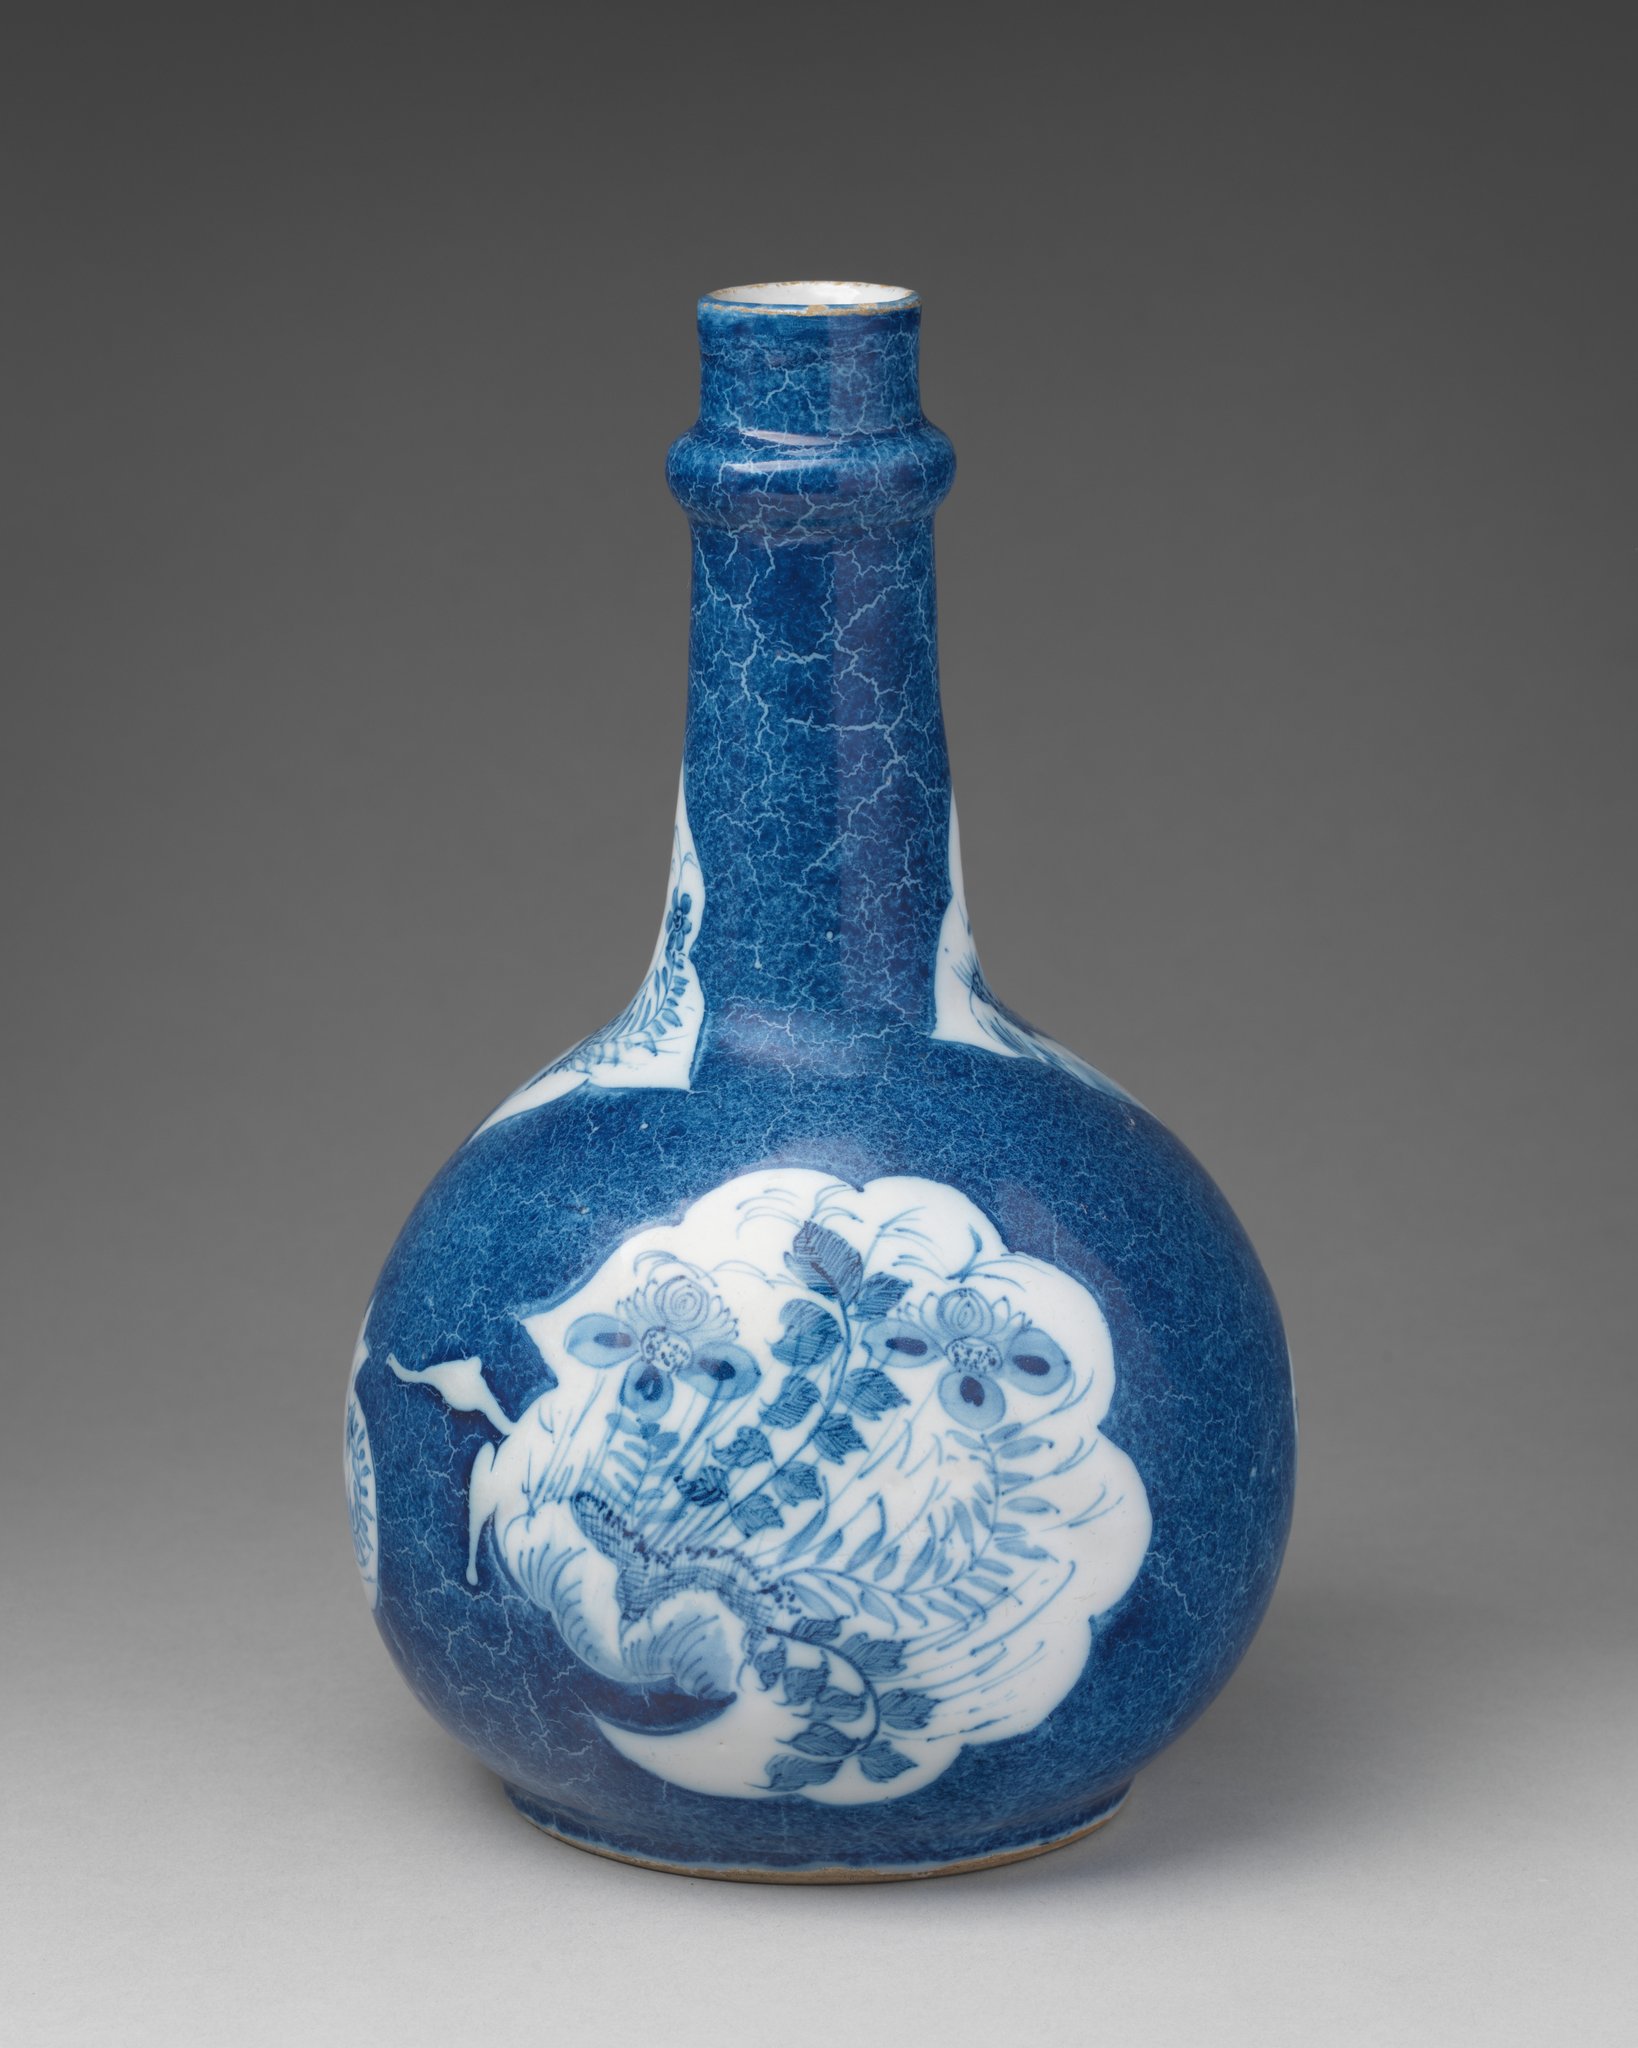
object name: bottle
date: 1734-1766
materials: earthenware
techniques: glazing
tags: flowers